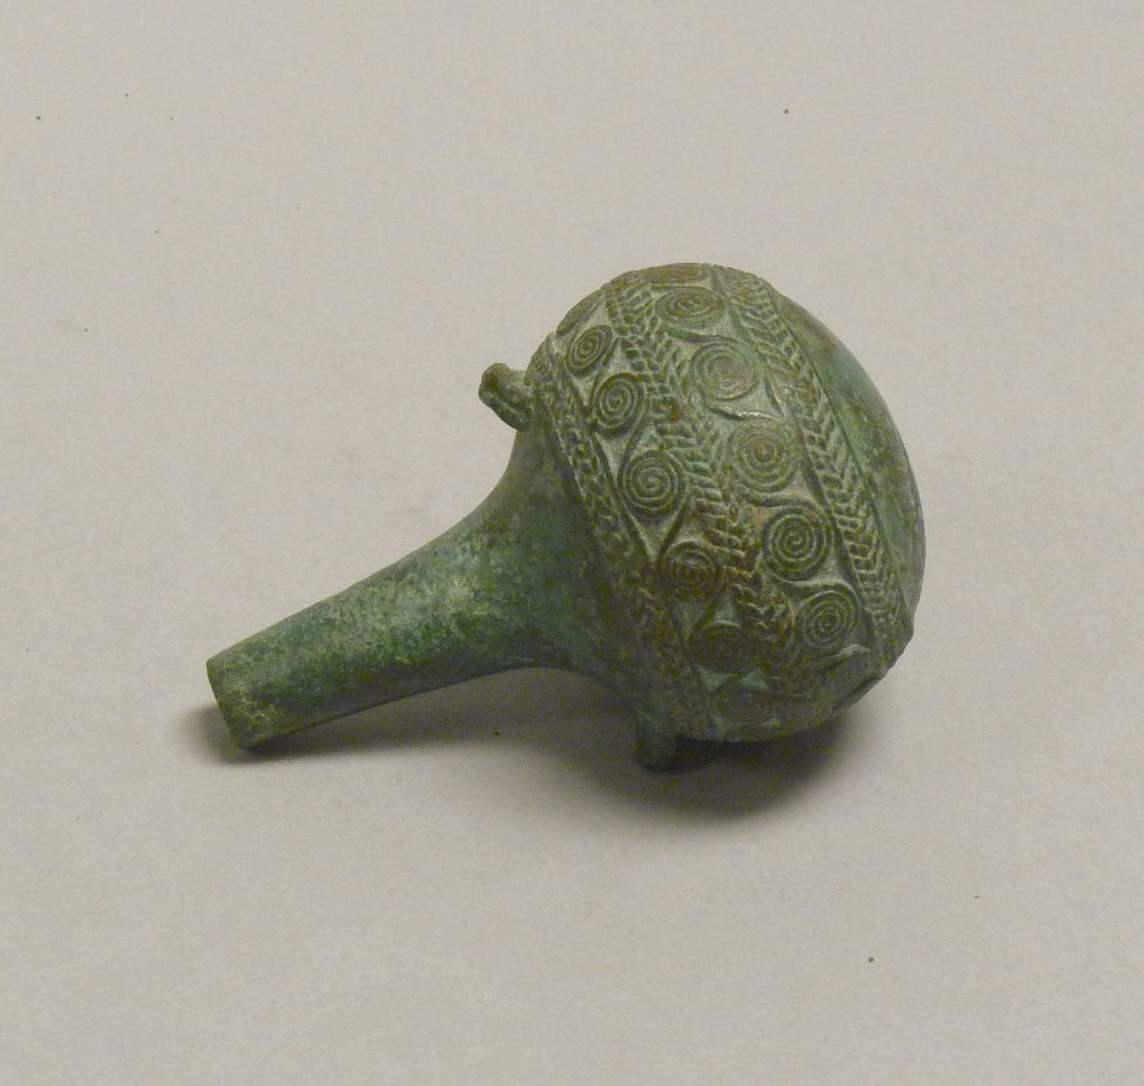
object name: vessel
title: Lime Vessel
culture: indonesian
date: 500 BCE-300 CE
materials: bronze